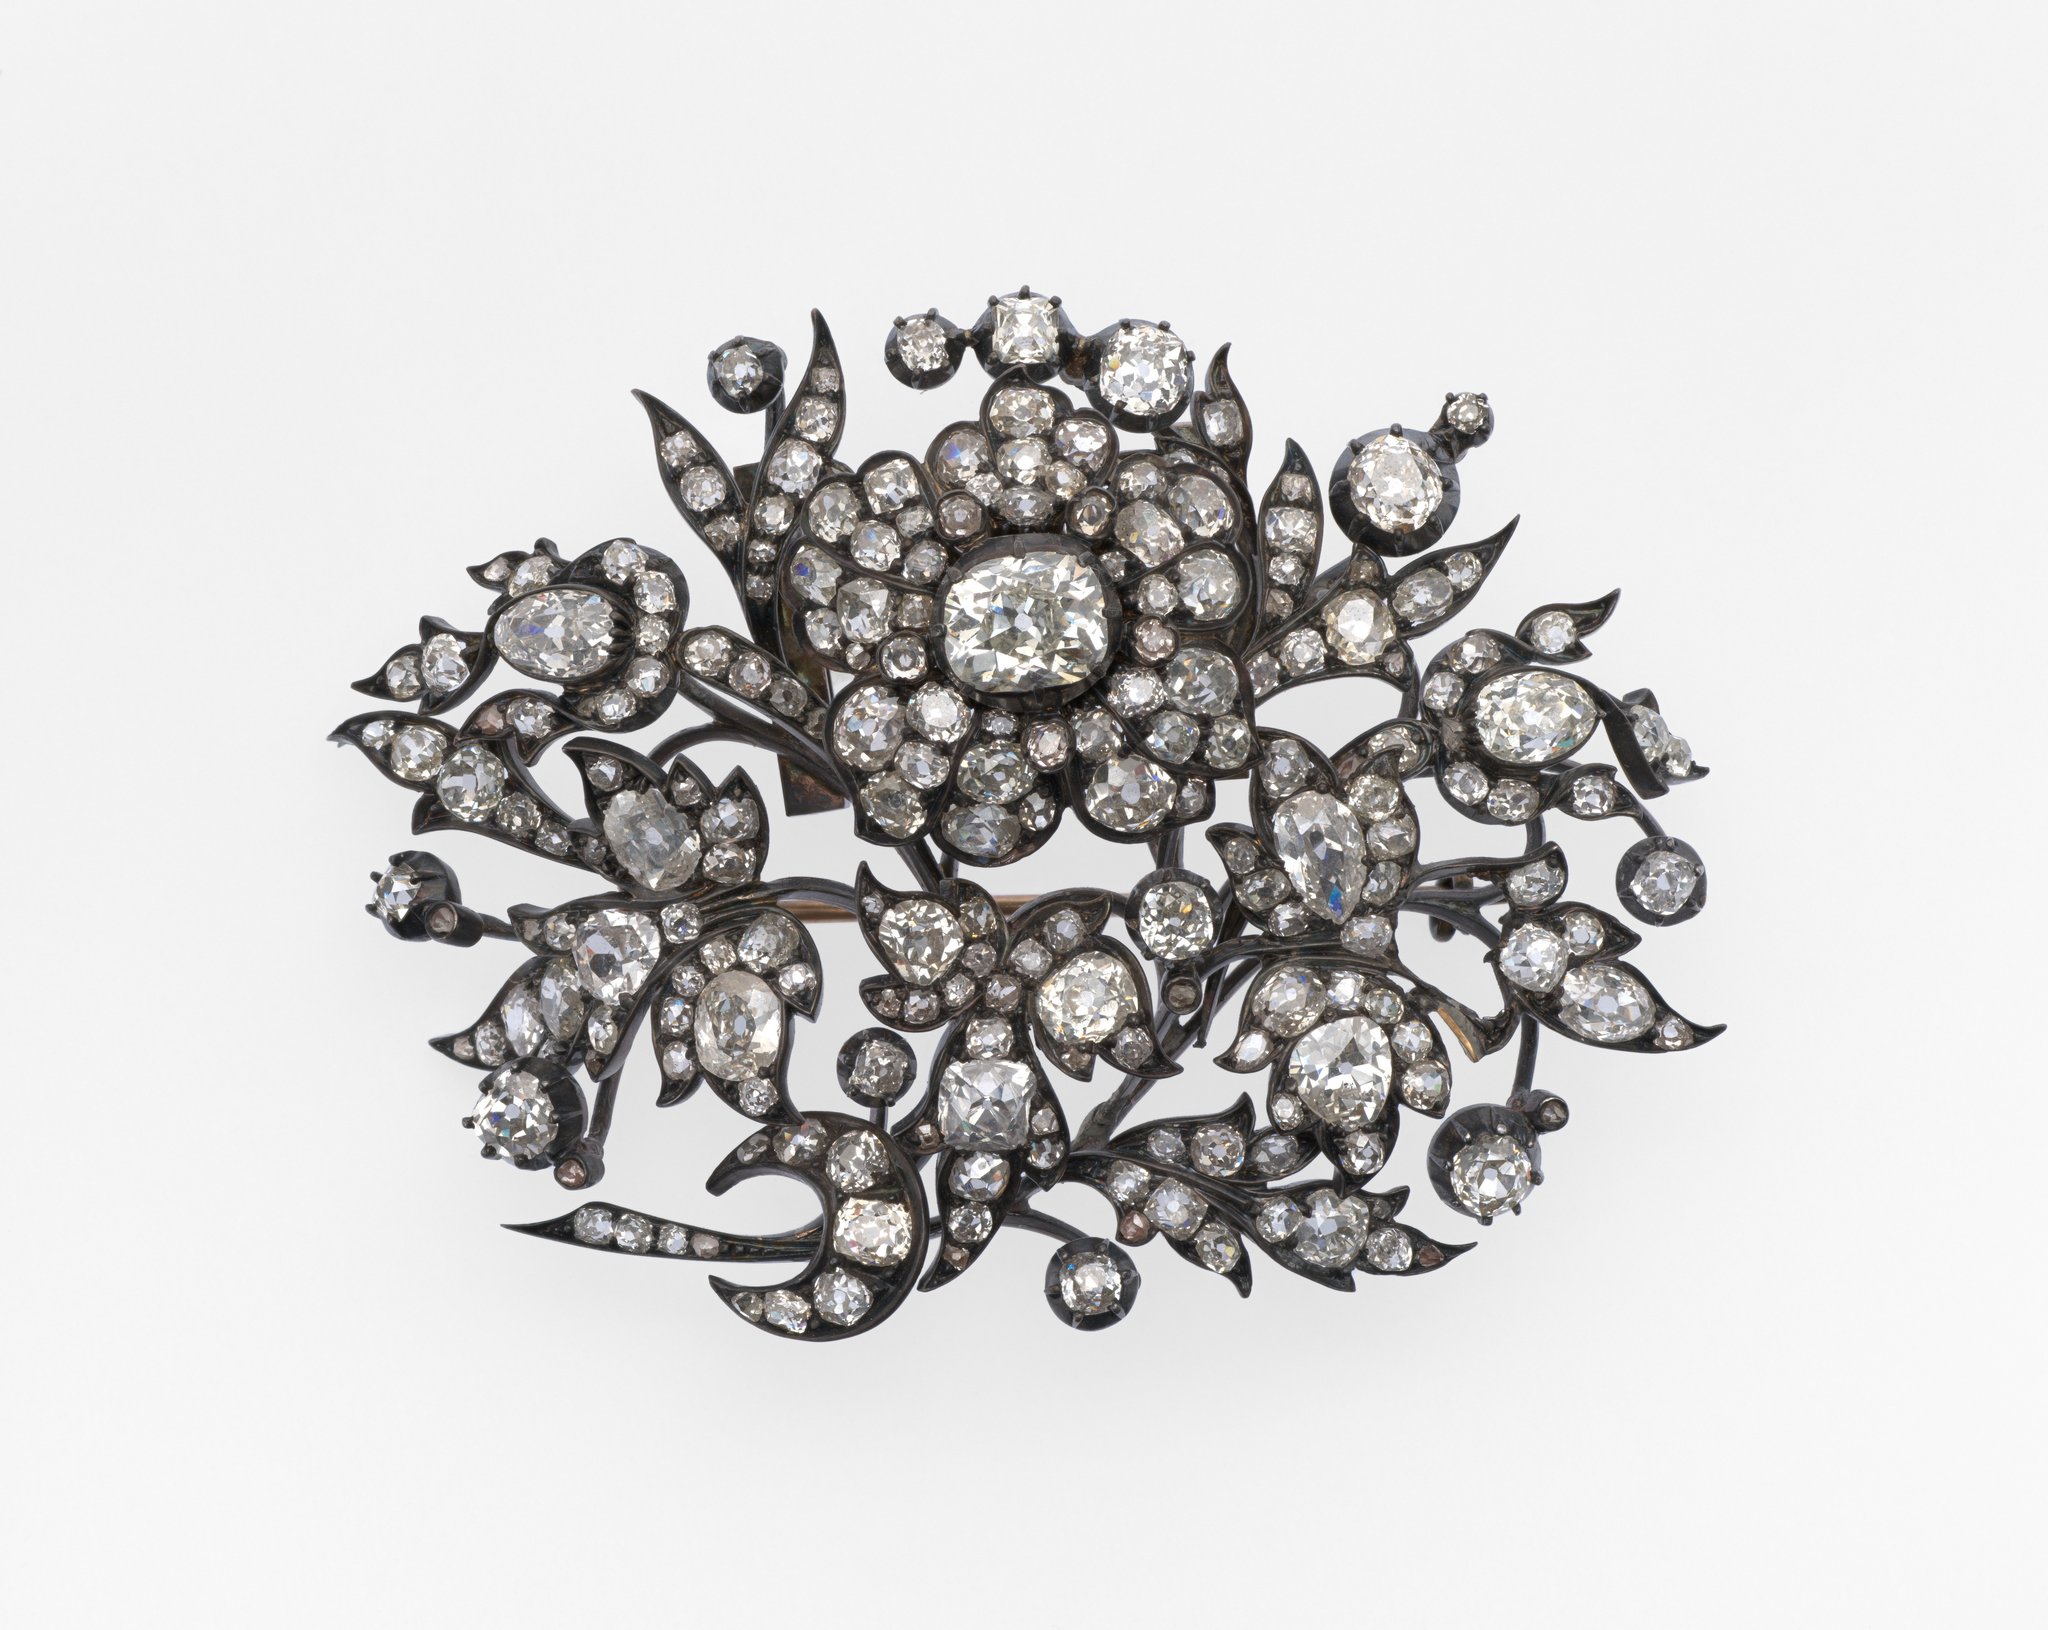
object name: brooch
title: Brooch (part of a hair ornament)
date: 1834-1866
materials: diamond, gold, silver